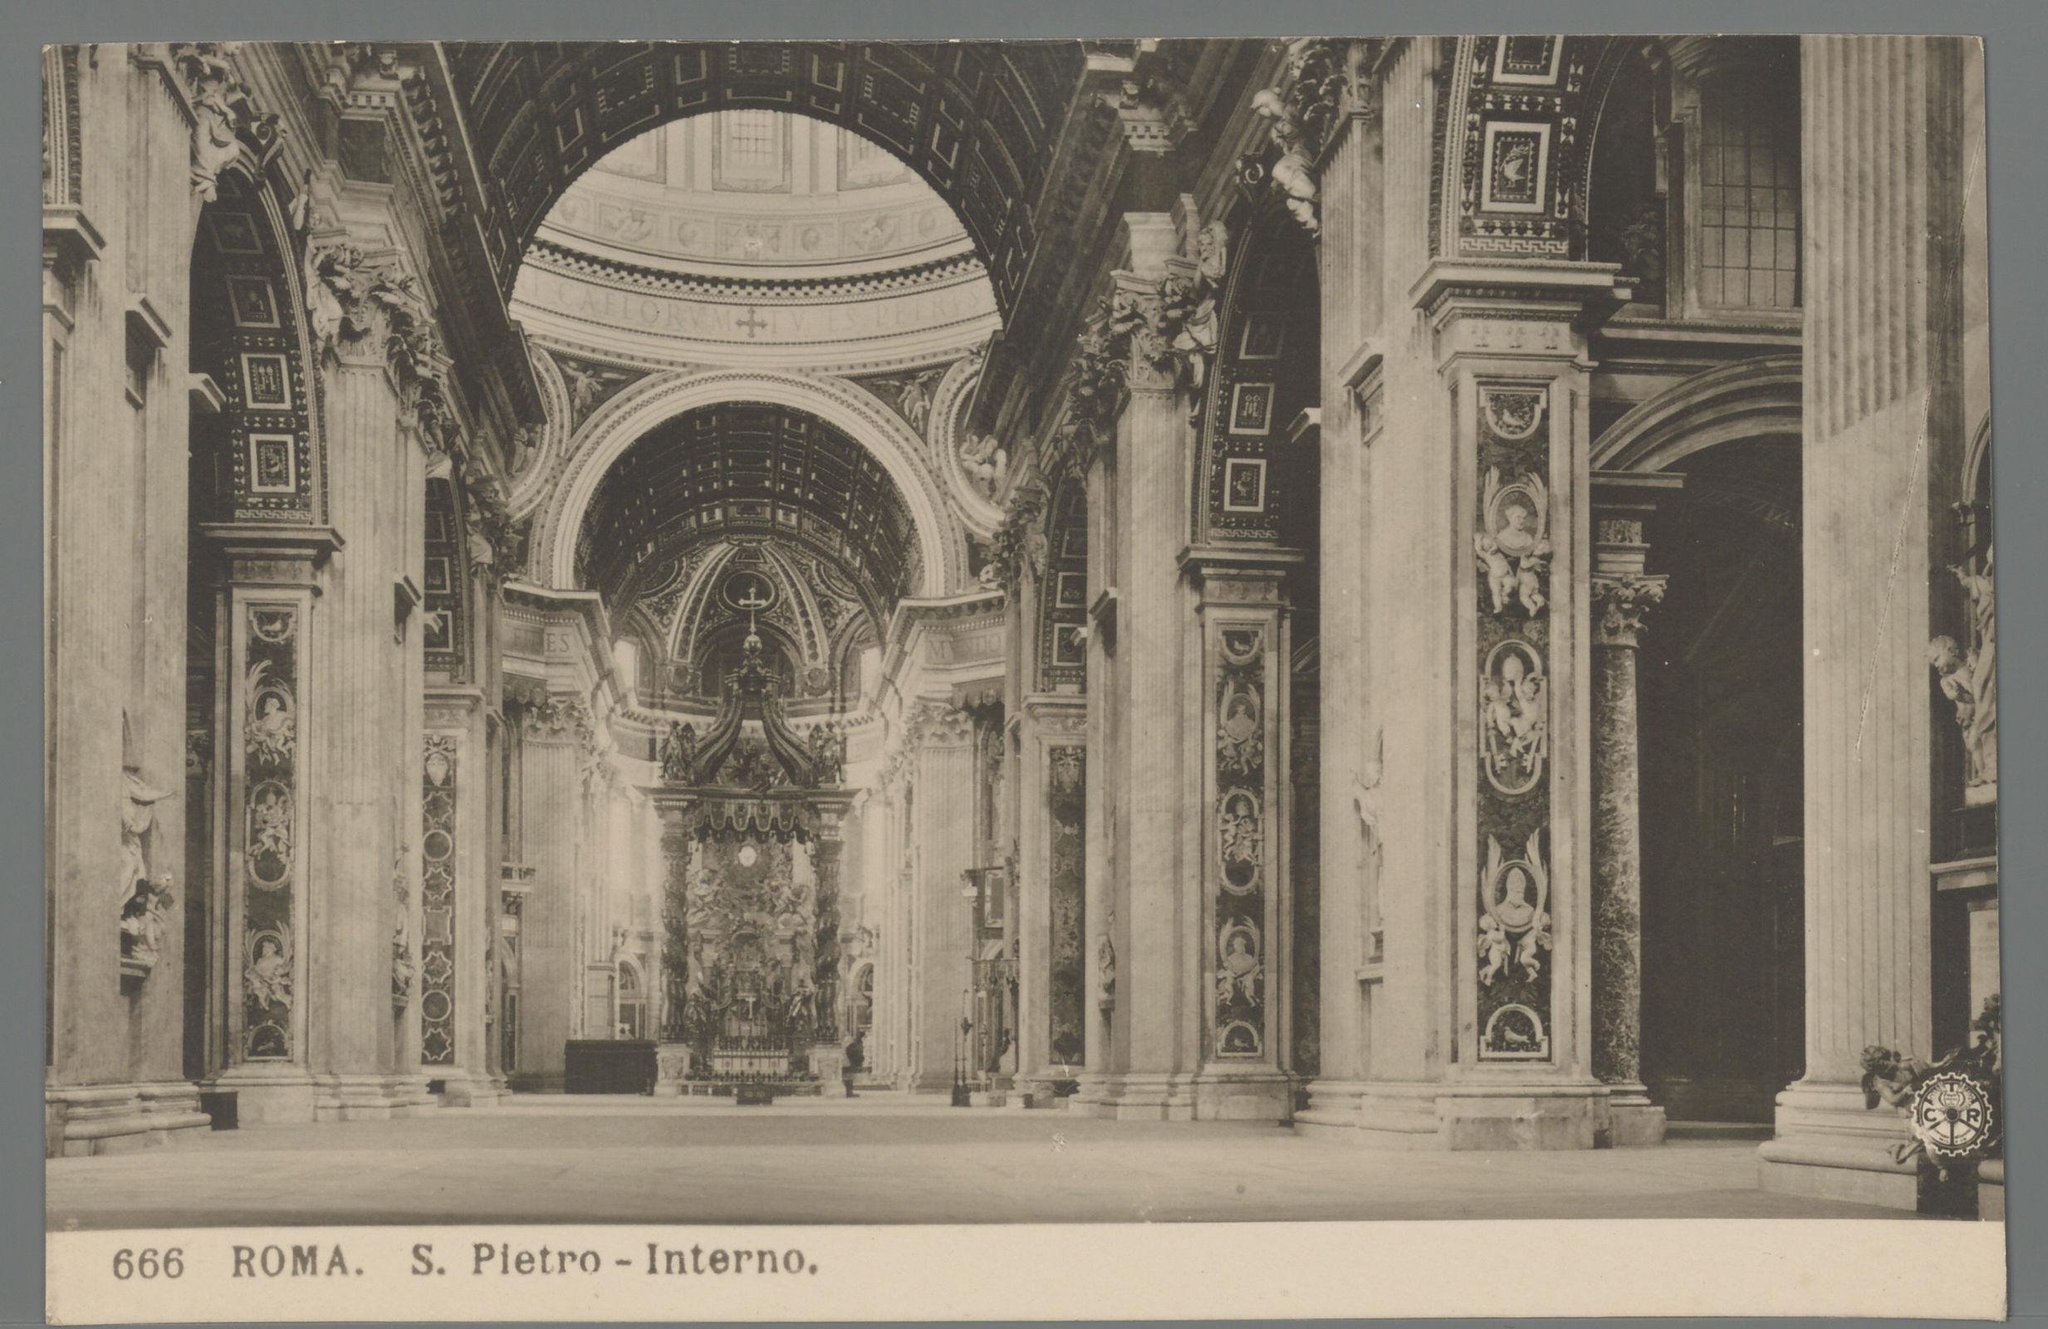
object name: photograph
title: Roma. S. Pietro. Interno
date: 1906-1920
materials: photographic support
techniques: photography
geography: italy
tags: interior of church